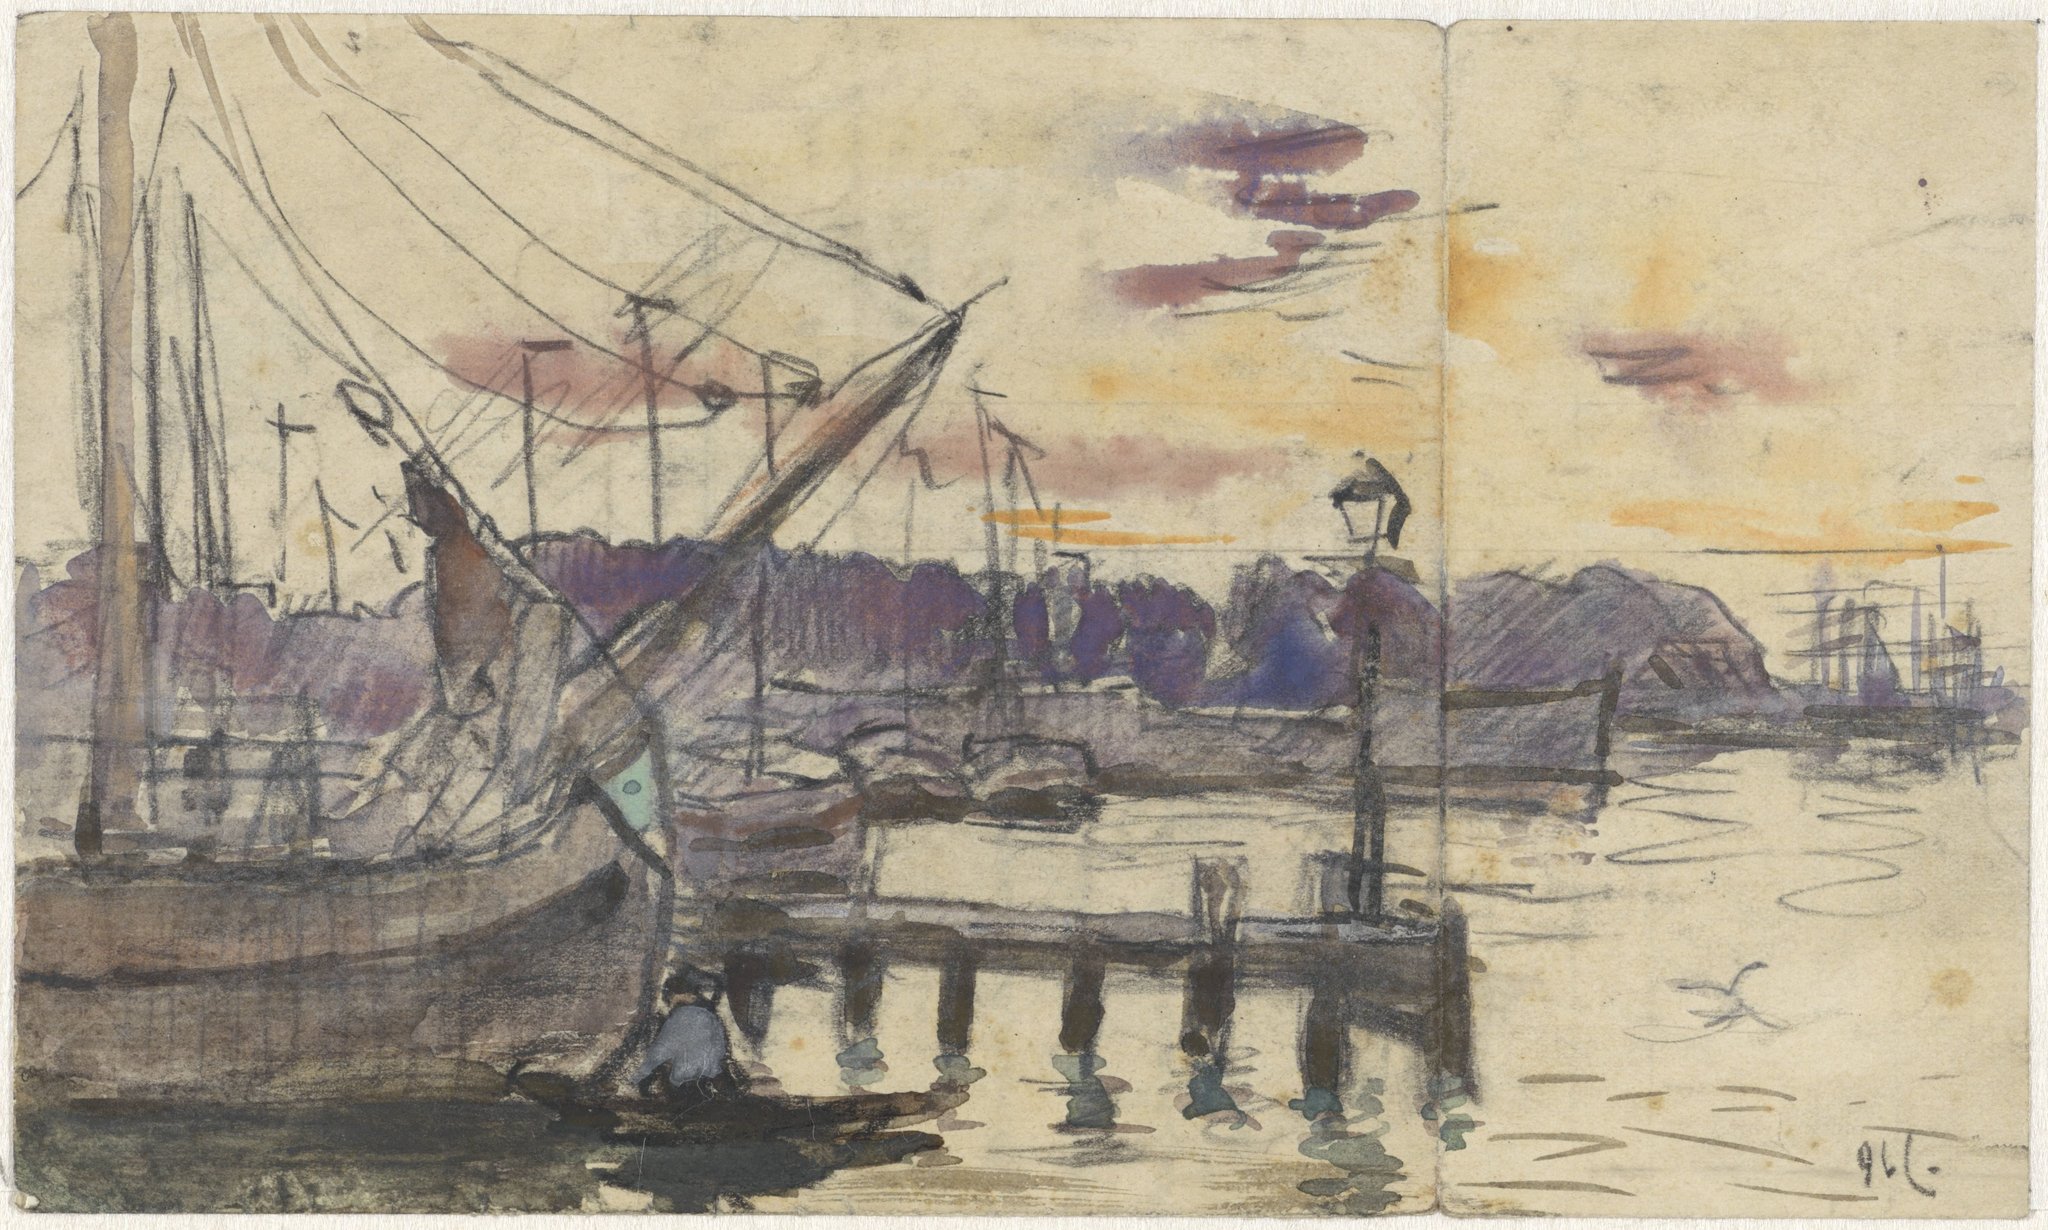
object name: drawing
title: Kade met schepen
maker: adolf le comte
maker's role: draughtsman, painter, print maker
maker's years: 1850-1921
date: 1860-1921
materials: chalk, paper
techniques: brush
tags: boat or vehicle drawn by (fabulous) animal(s) of the sea